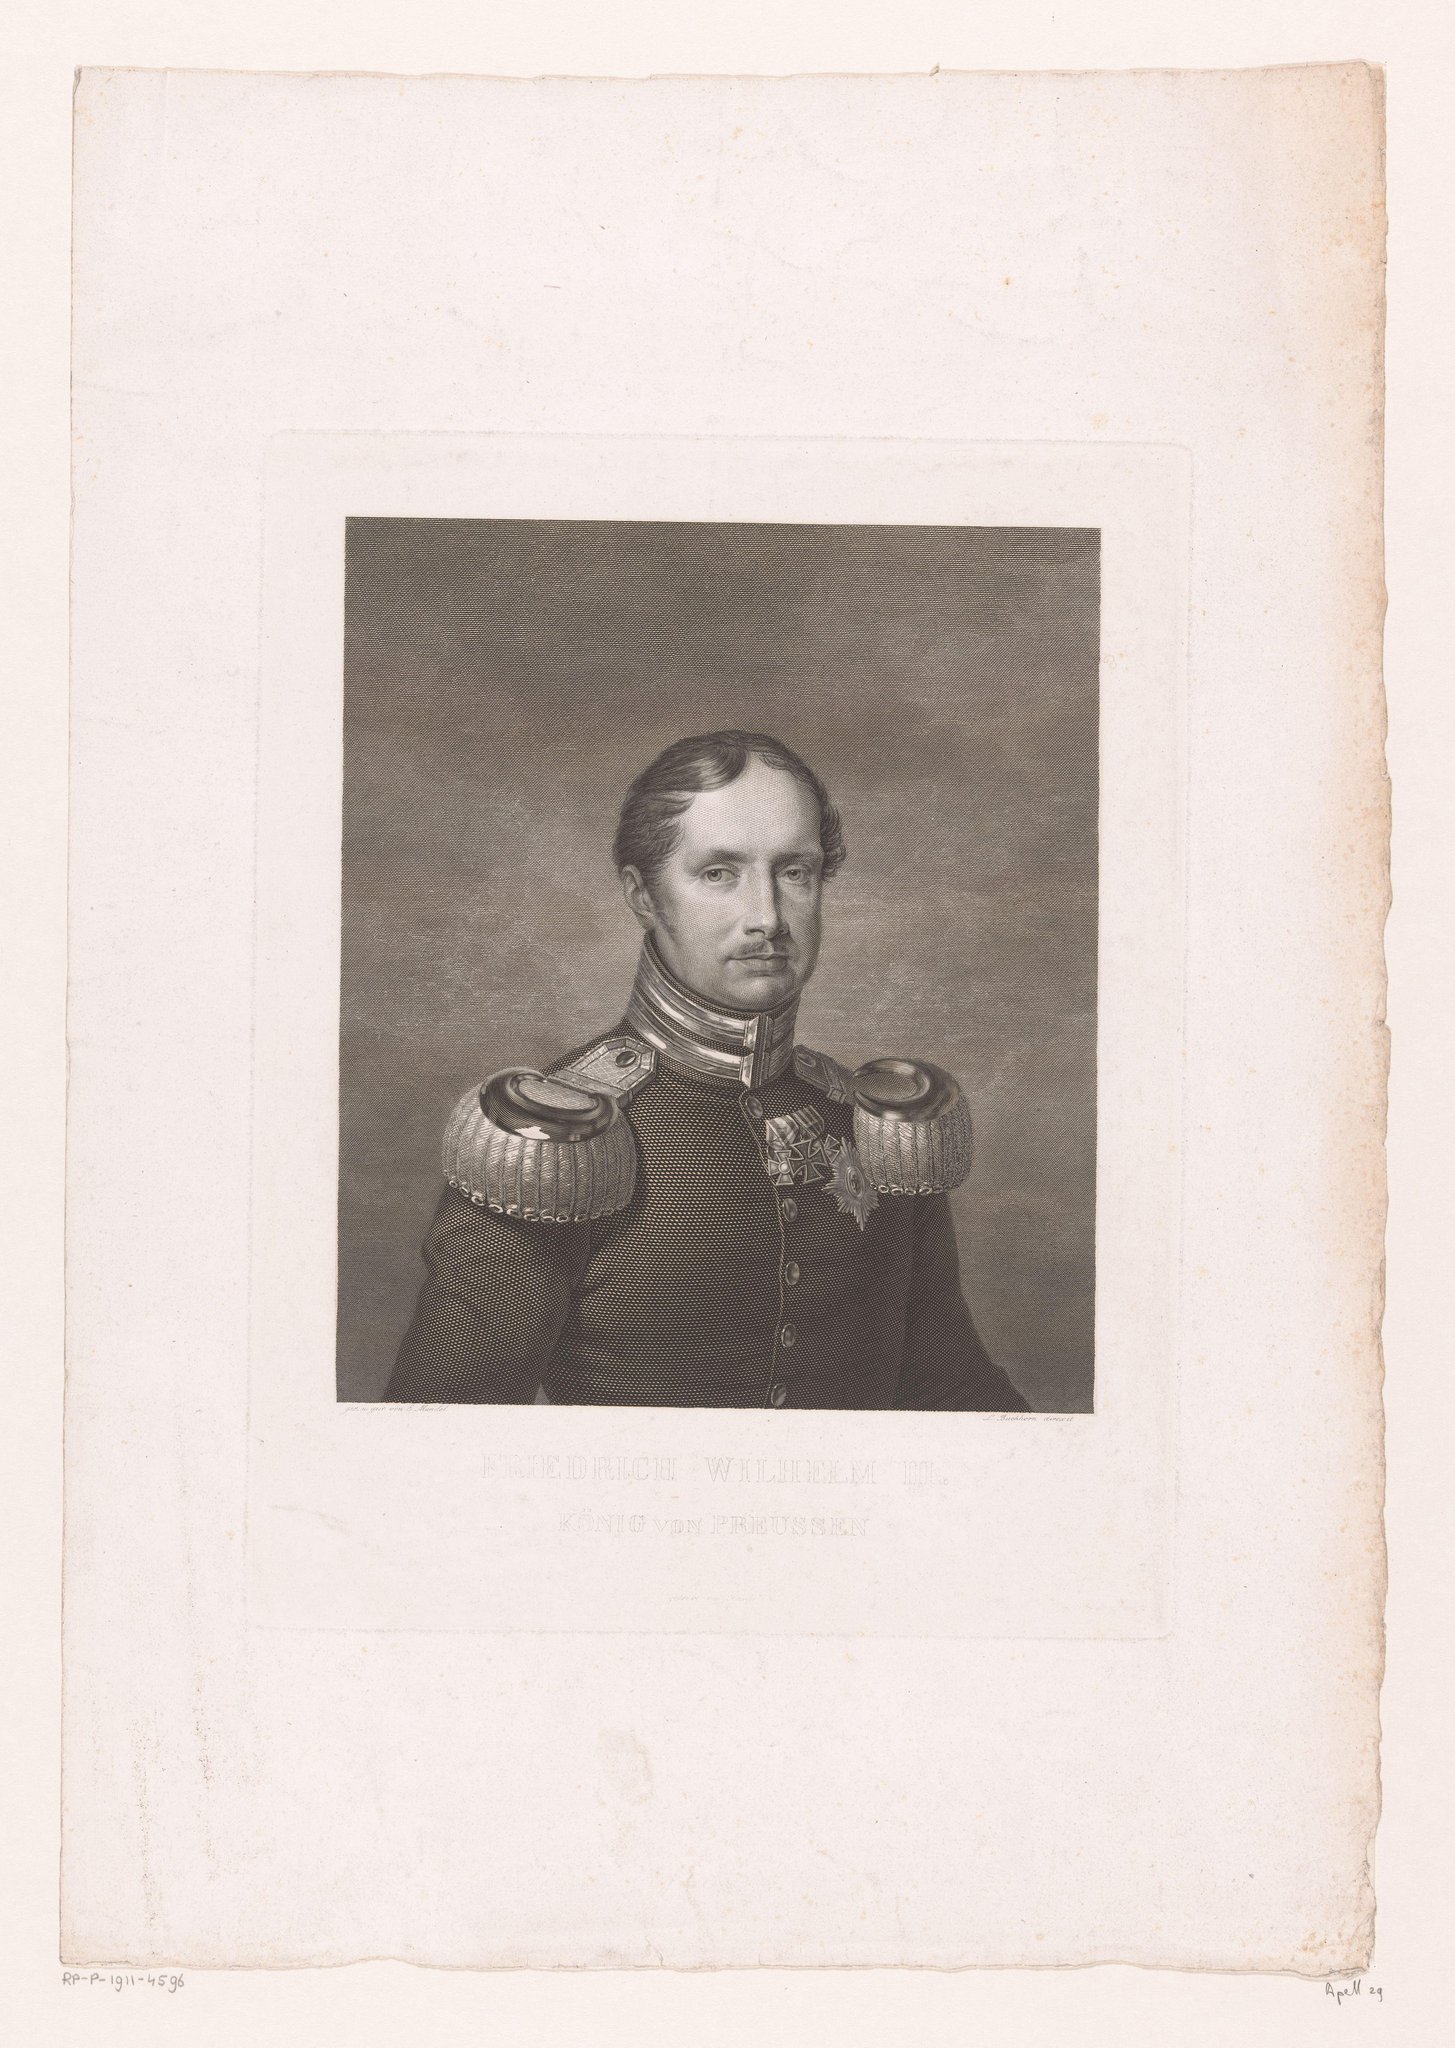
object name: print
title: Portret van Friedrich Wilhelm III van Pruissen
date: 1820-1882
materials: paper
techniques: engraving, etching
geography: berlin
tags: berlin, frederik willem iii koning van pruisen, historical persons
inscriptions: collector's mark: Lugt 2228